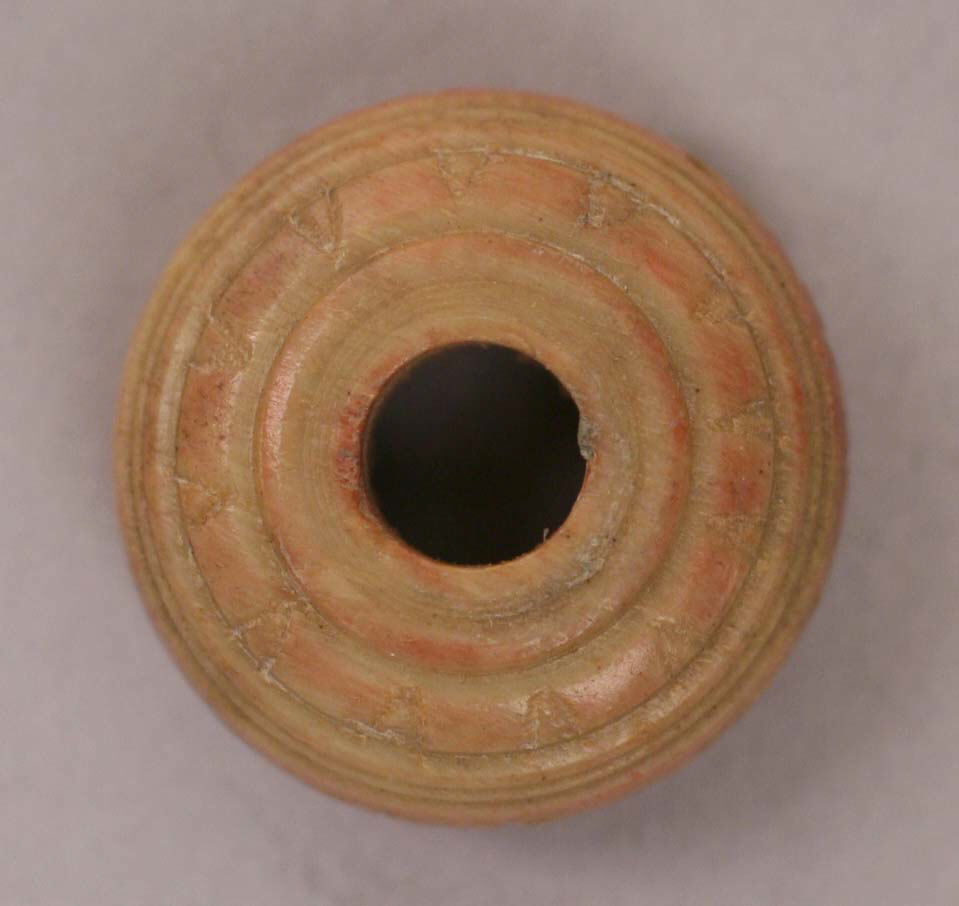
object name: button or bead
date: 801-1000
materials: bone, paint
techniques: incising, inlay, tinting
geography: iran